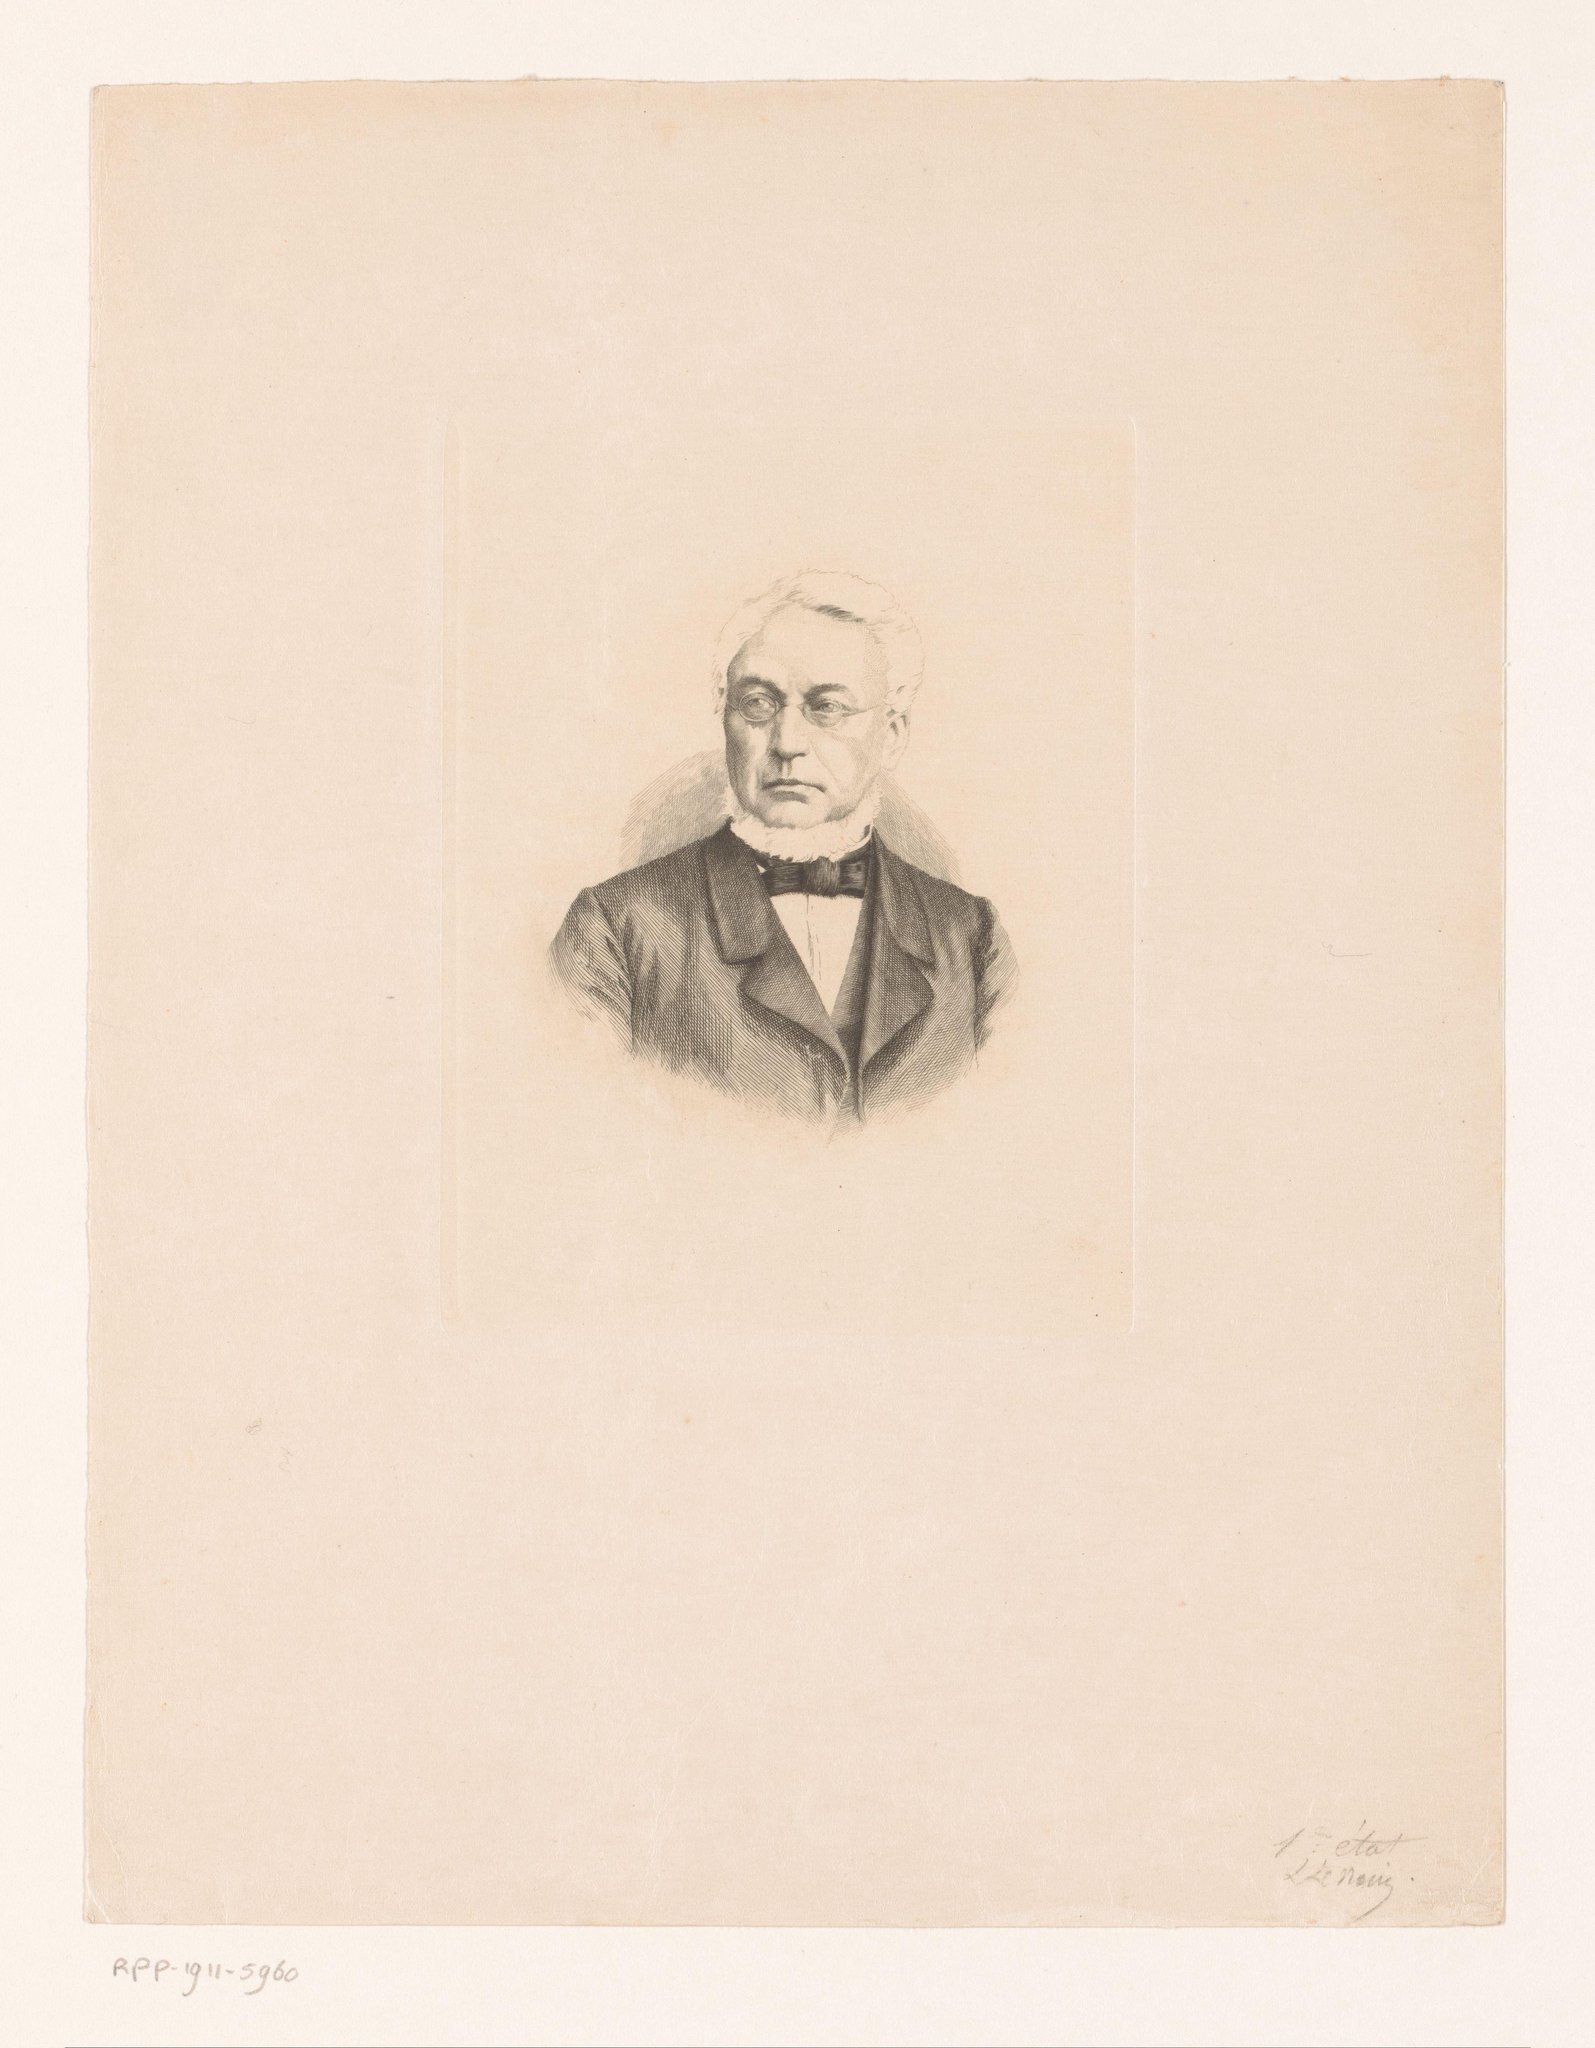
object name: print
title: Portret van Pierre-Henri Nyst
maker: louis le nain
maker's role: print maker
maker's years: 1851-1939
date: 1861-1911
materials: paper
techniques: etching, intaglio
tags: eyeglasses, spectacles, adult man, historical persons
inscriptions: inscription: ‘1e état LLe Nain’, collector's mark: Lugt 2228